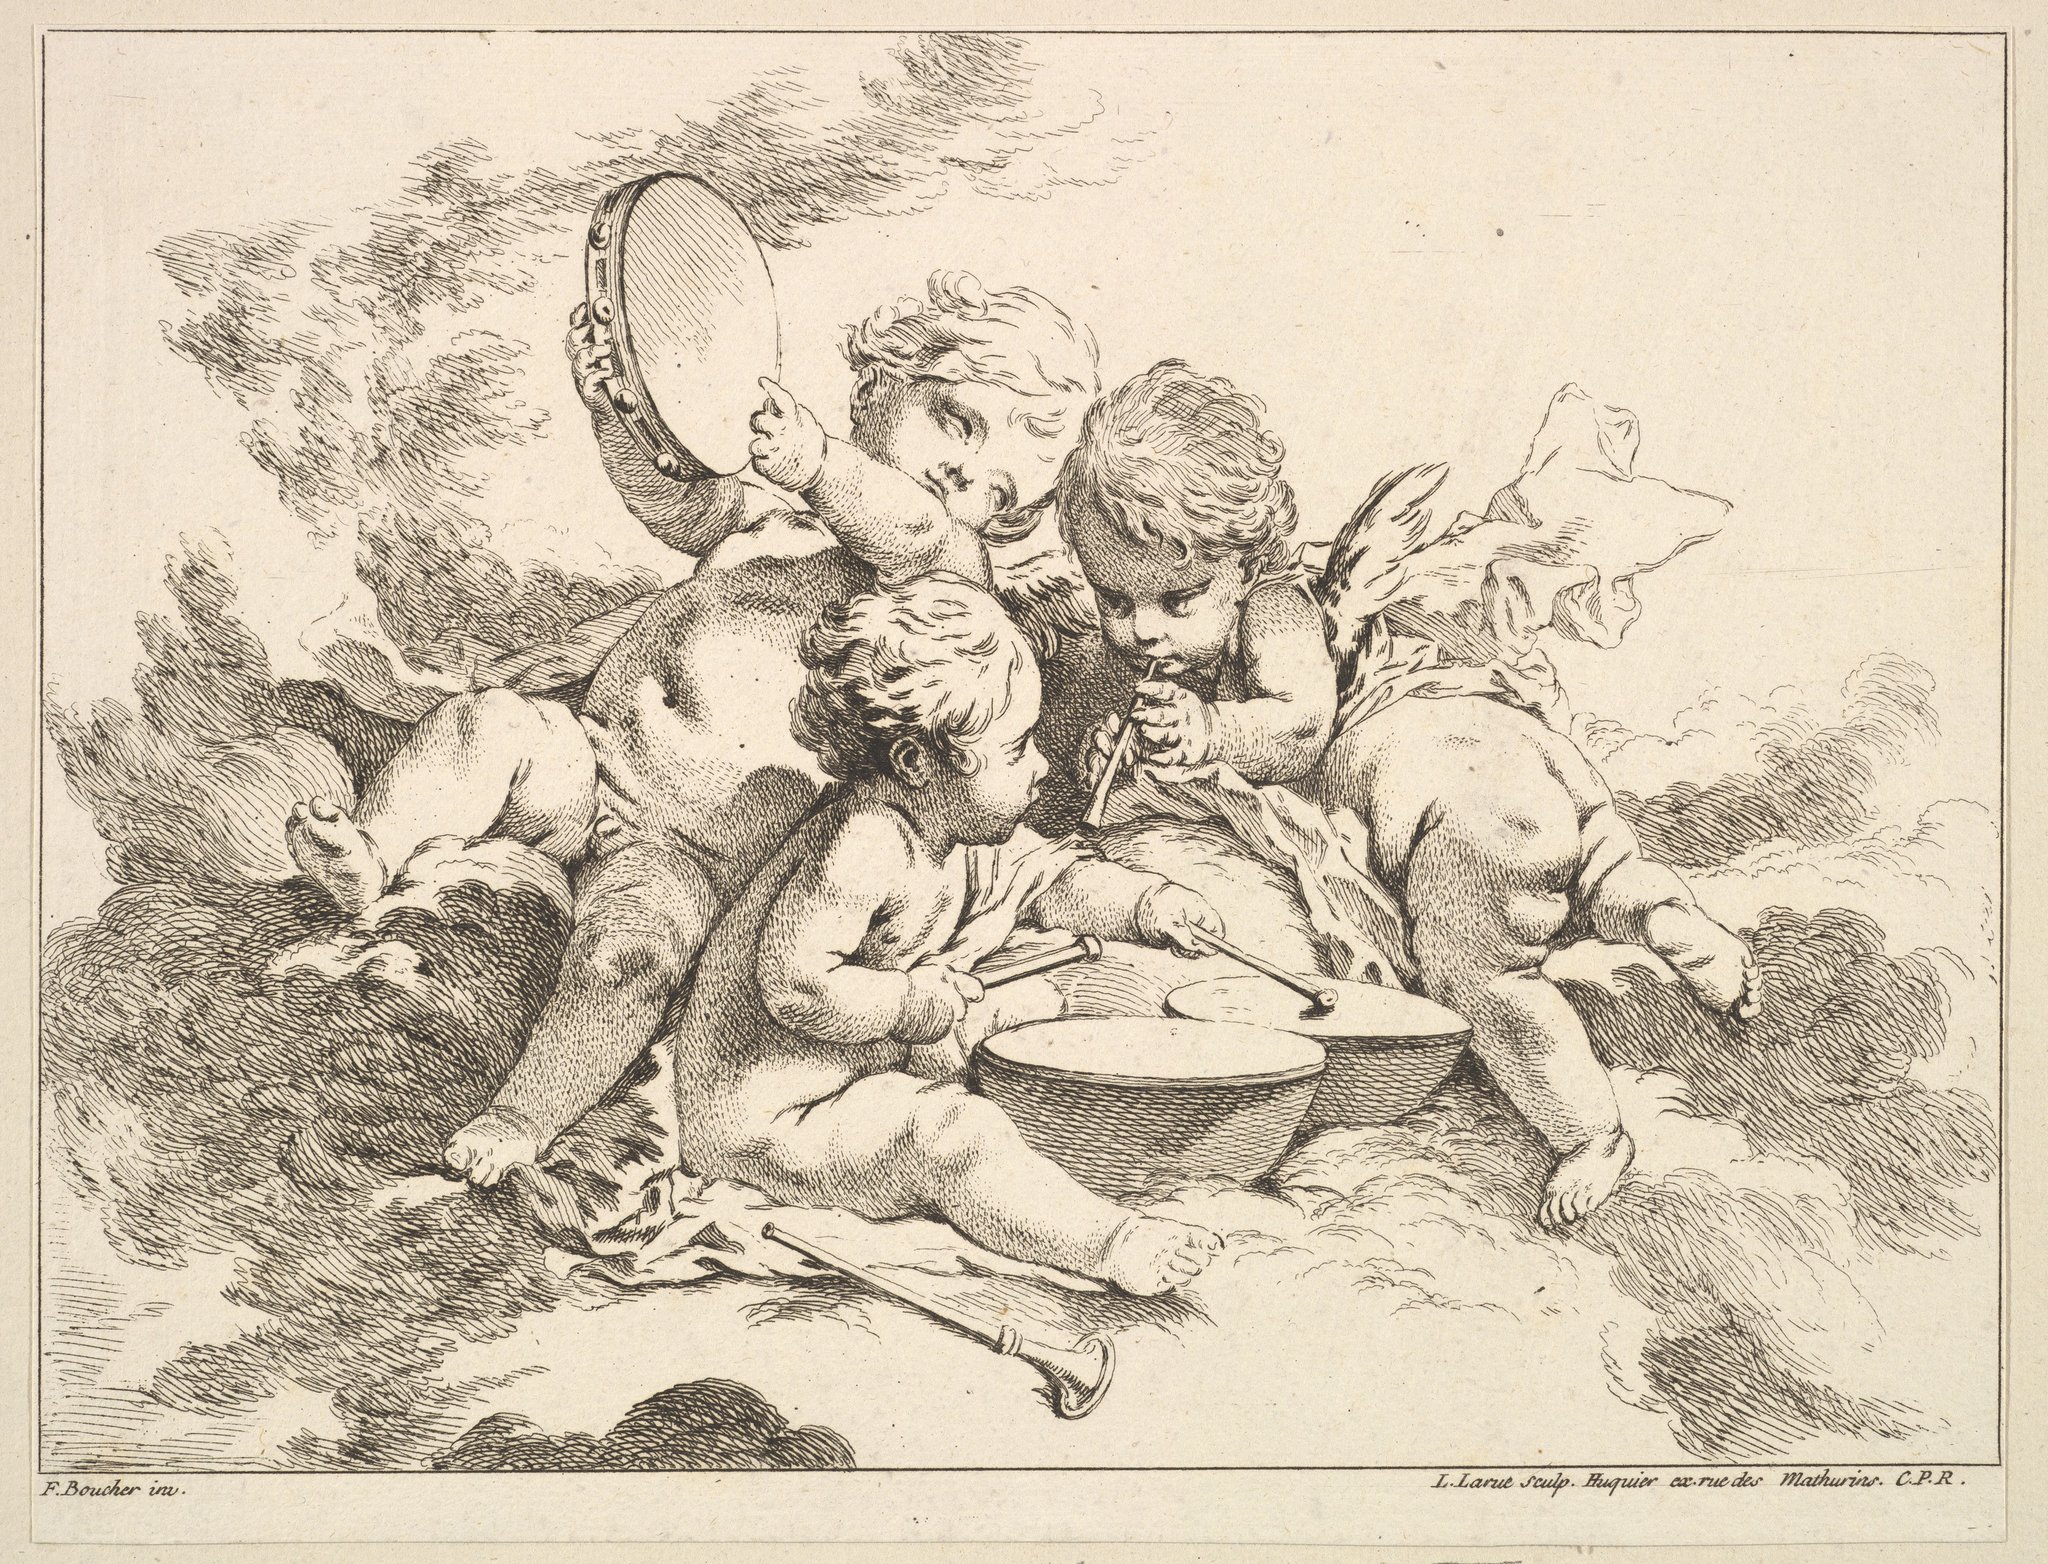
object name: print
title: Earth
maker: louis félix de la rue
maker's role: artist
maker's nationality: french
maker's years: 1731-1765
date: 1731-1765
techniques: etching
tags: musical instruments,music